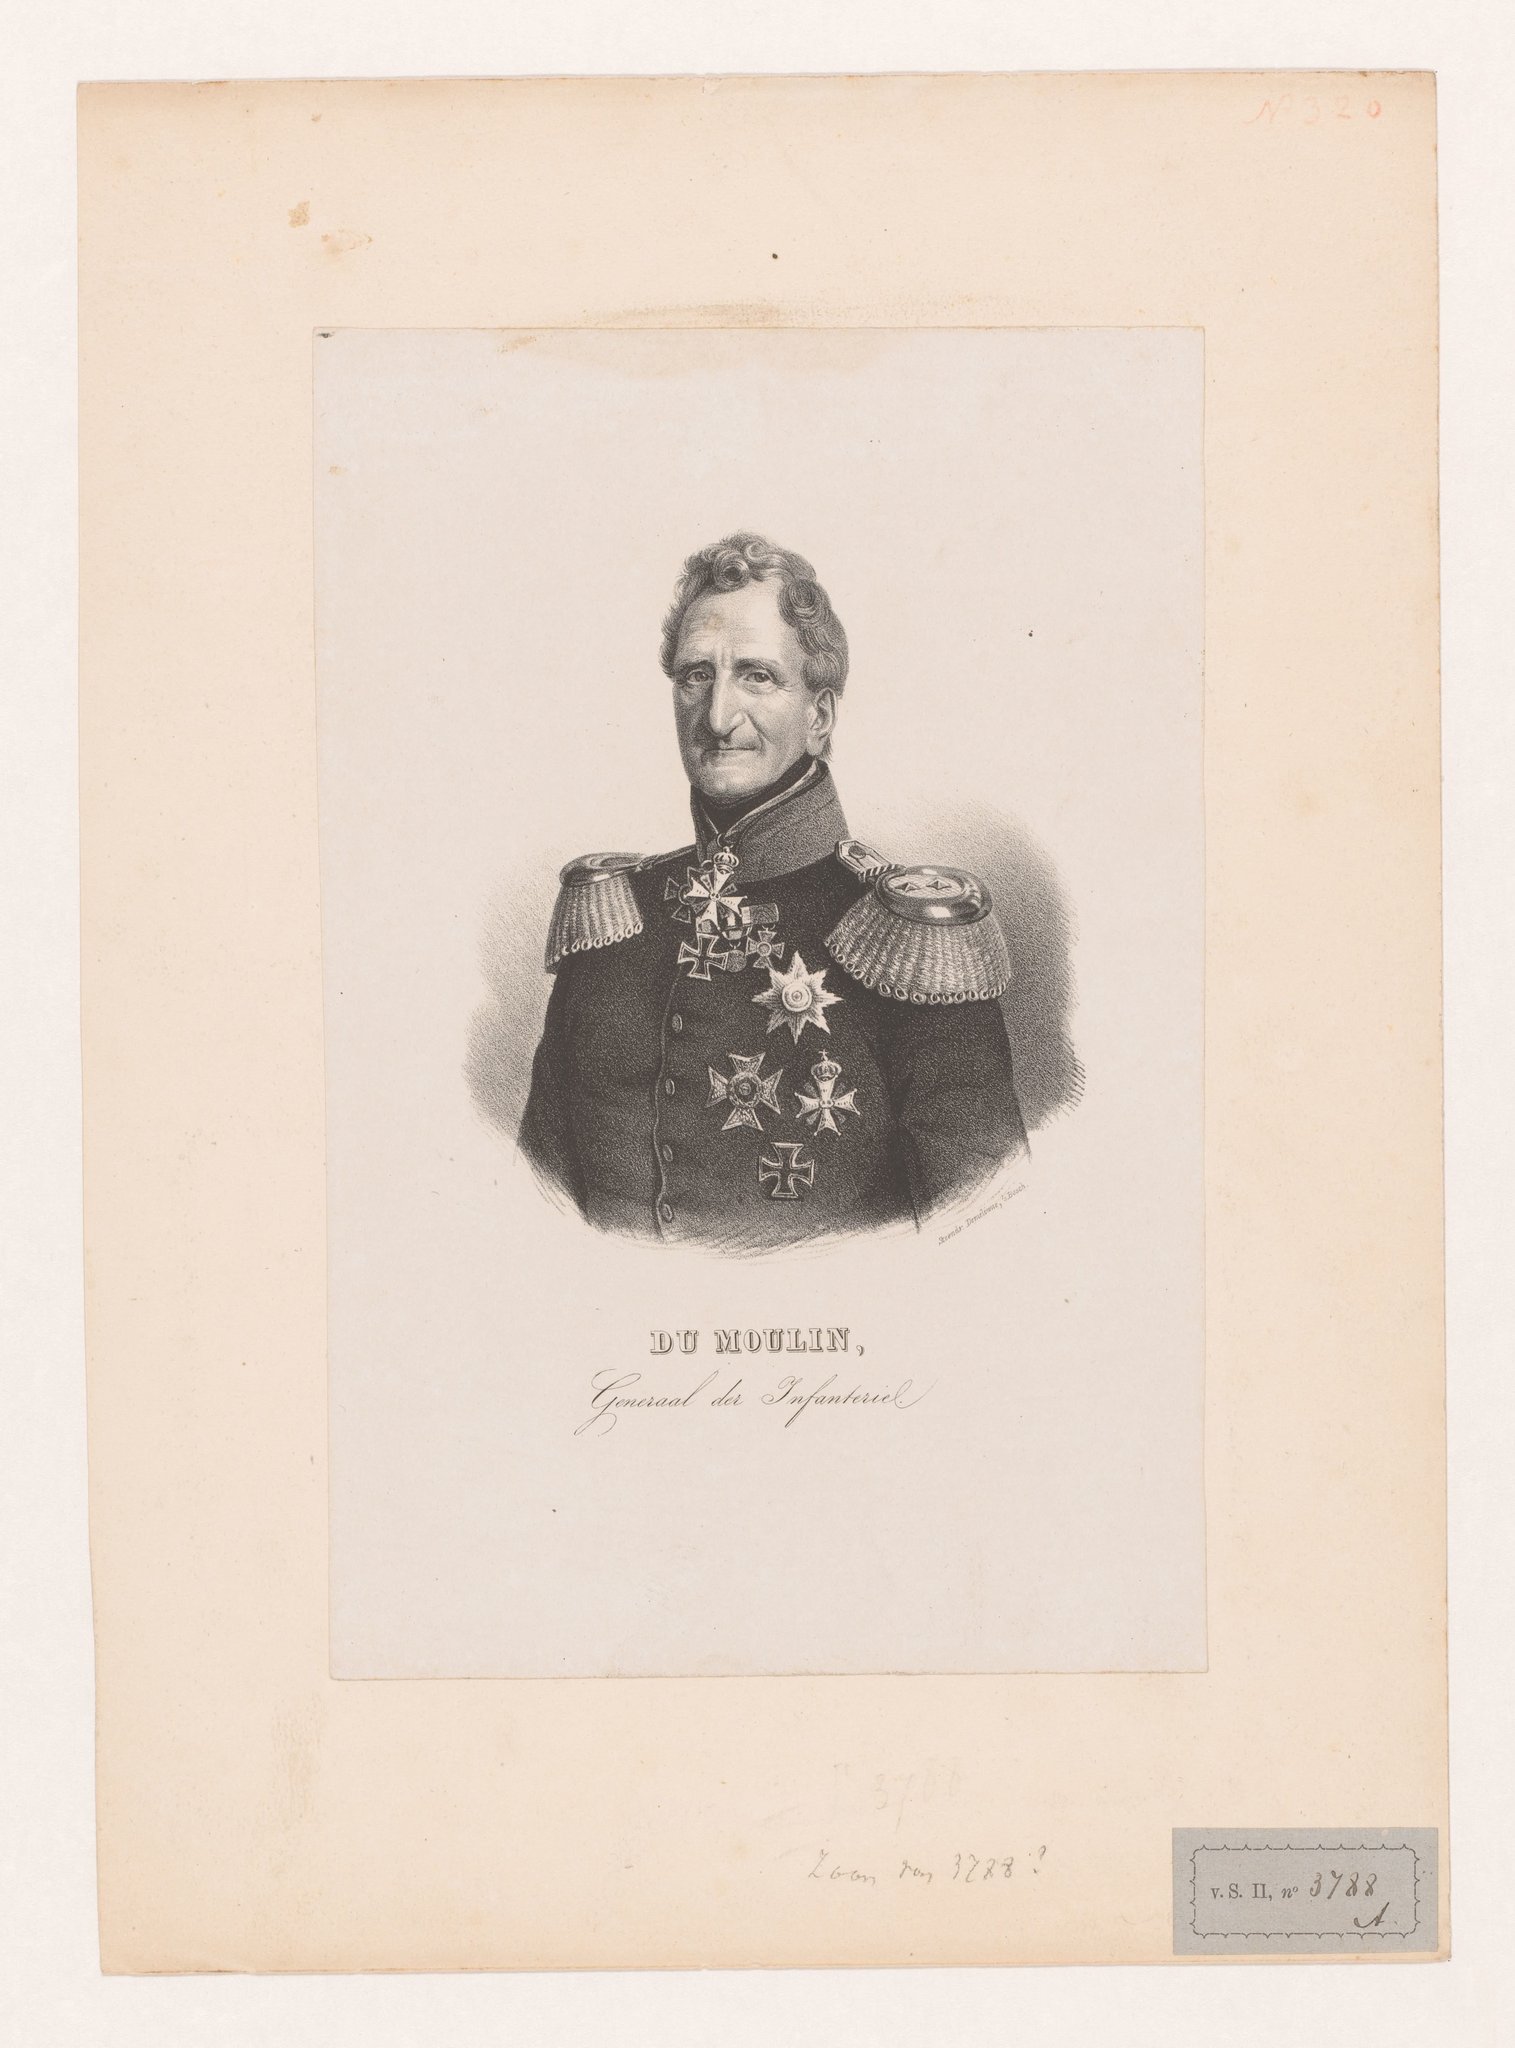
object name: print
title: Portret van Ferdinand Jacobus du Moulin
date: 1836-1861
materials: paper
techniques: lithograph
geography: den bosch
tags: knighthood order, historical persons (+ (full) bust portrait)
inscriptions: collector's mark: Lugt 2228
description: De geportretteerde draagt een uniform met negen onderscheidingen, waaronder de militaire Willemsorde, en epauletten met twee sterren. Onder het portret zijn naam en beroep.